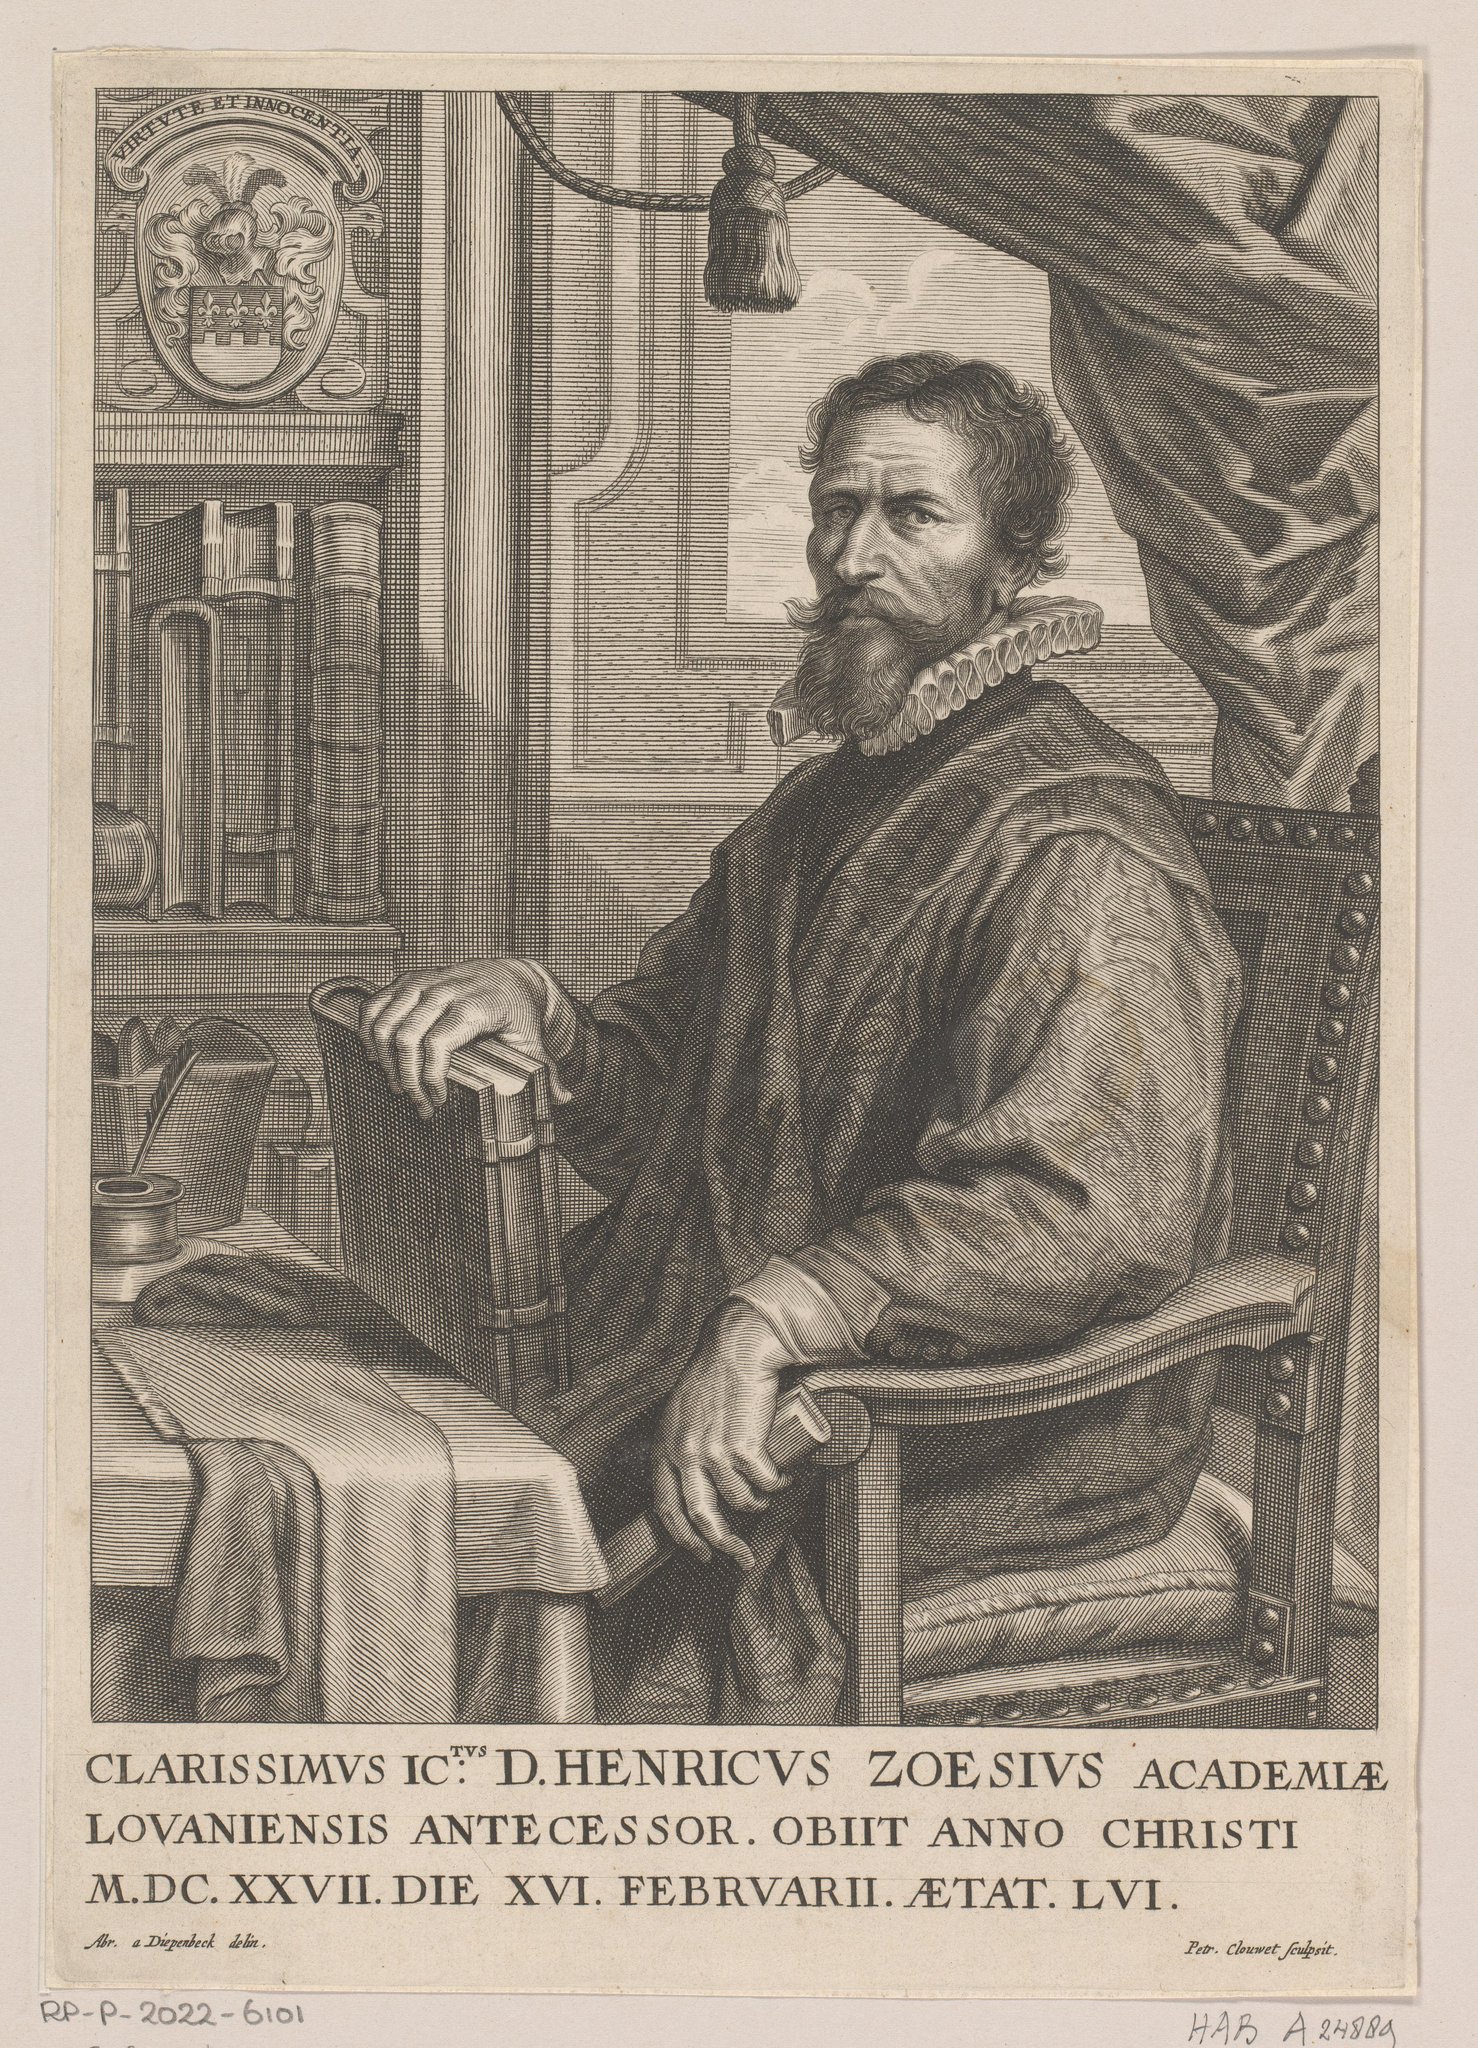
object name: print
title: Portret van Hendrik Zoesius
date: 1639-1670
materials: paper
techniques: engraving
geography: antwerp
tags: louvain, historical persons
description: Met drieregelig onderschrift in het Latijn.